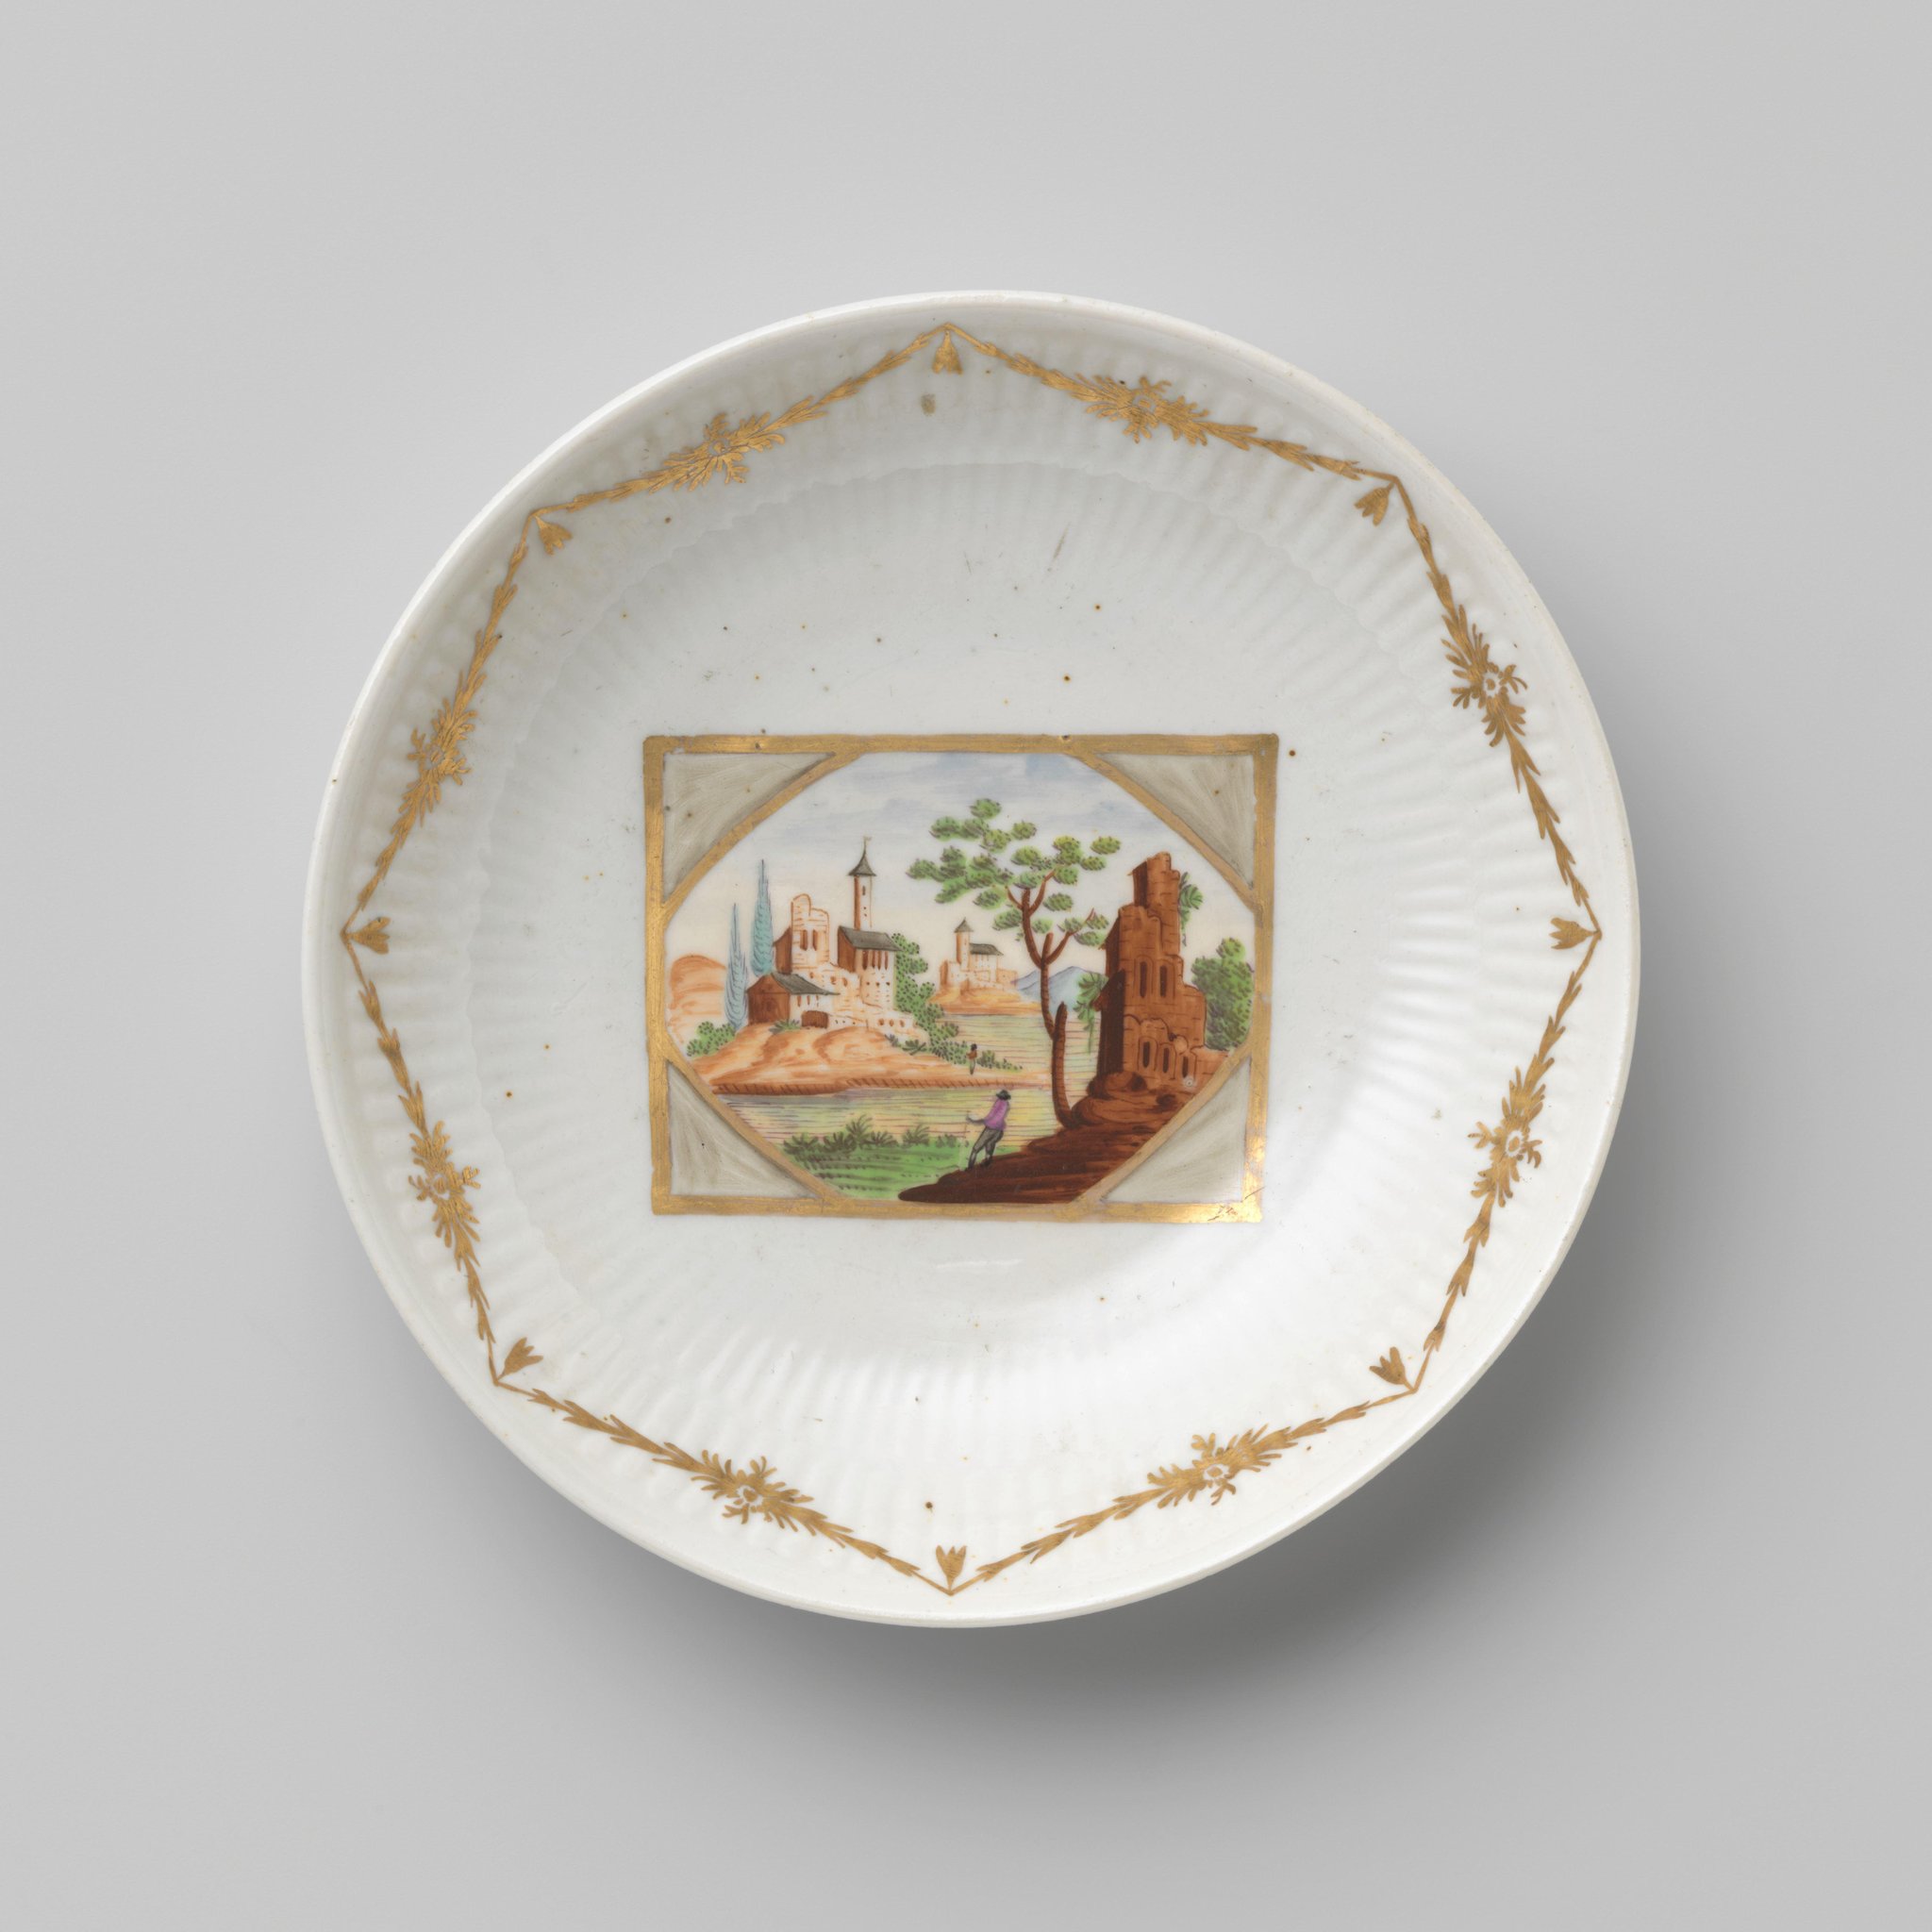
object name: platter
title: Saucer with a water landscape and garlands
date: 1780-1800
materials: glaze, gold, paint, porcelain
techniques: firing, forming, gilding, turning, vitrification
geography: wallendorf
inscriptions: mark: ‘W/ 8’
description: Schotel van porselein met een licht geribde wand, beschilderd op het glazuur in emailkleuren en goud. Op het plat een rechthoekig vak met in een ovaal medaillon een rivierlandschap met een persoon op de oever naast een ruïne. Op de achtergrond enkele gebouwen. De wand met een band van guirlandes. Gemerkt op de onderzijde met de W en 8.